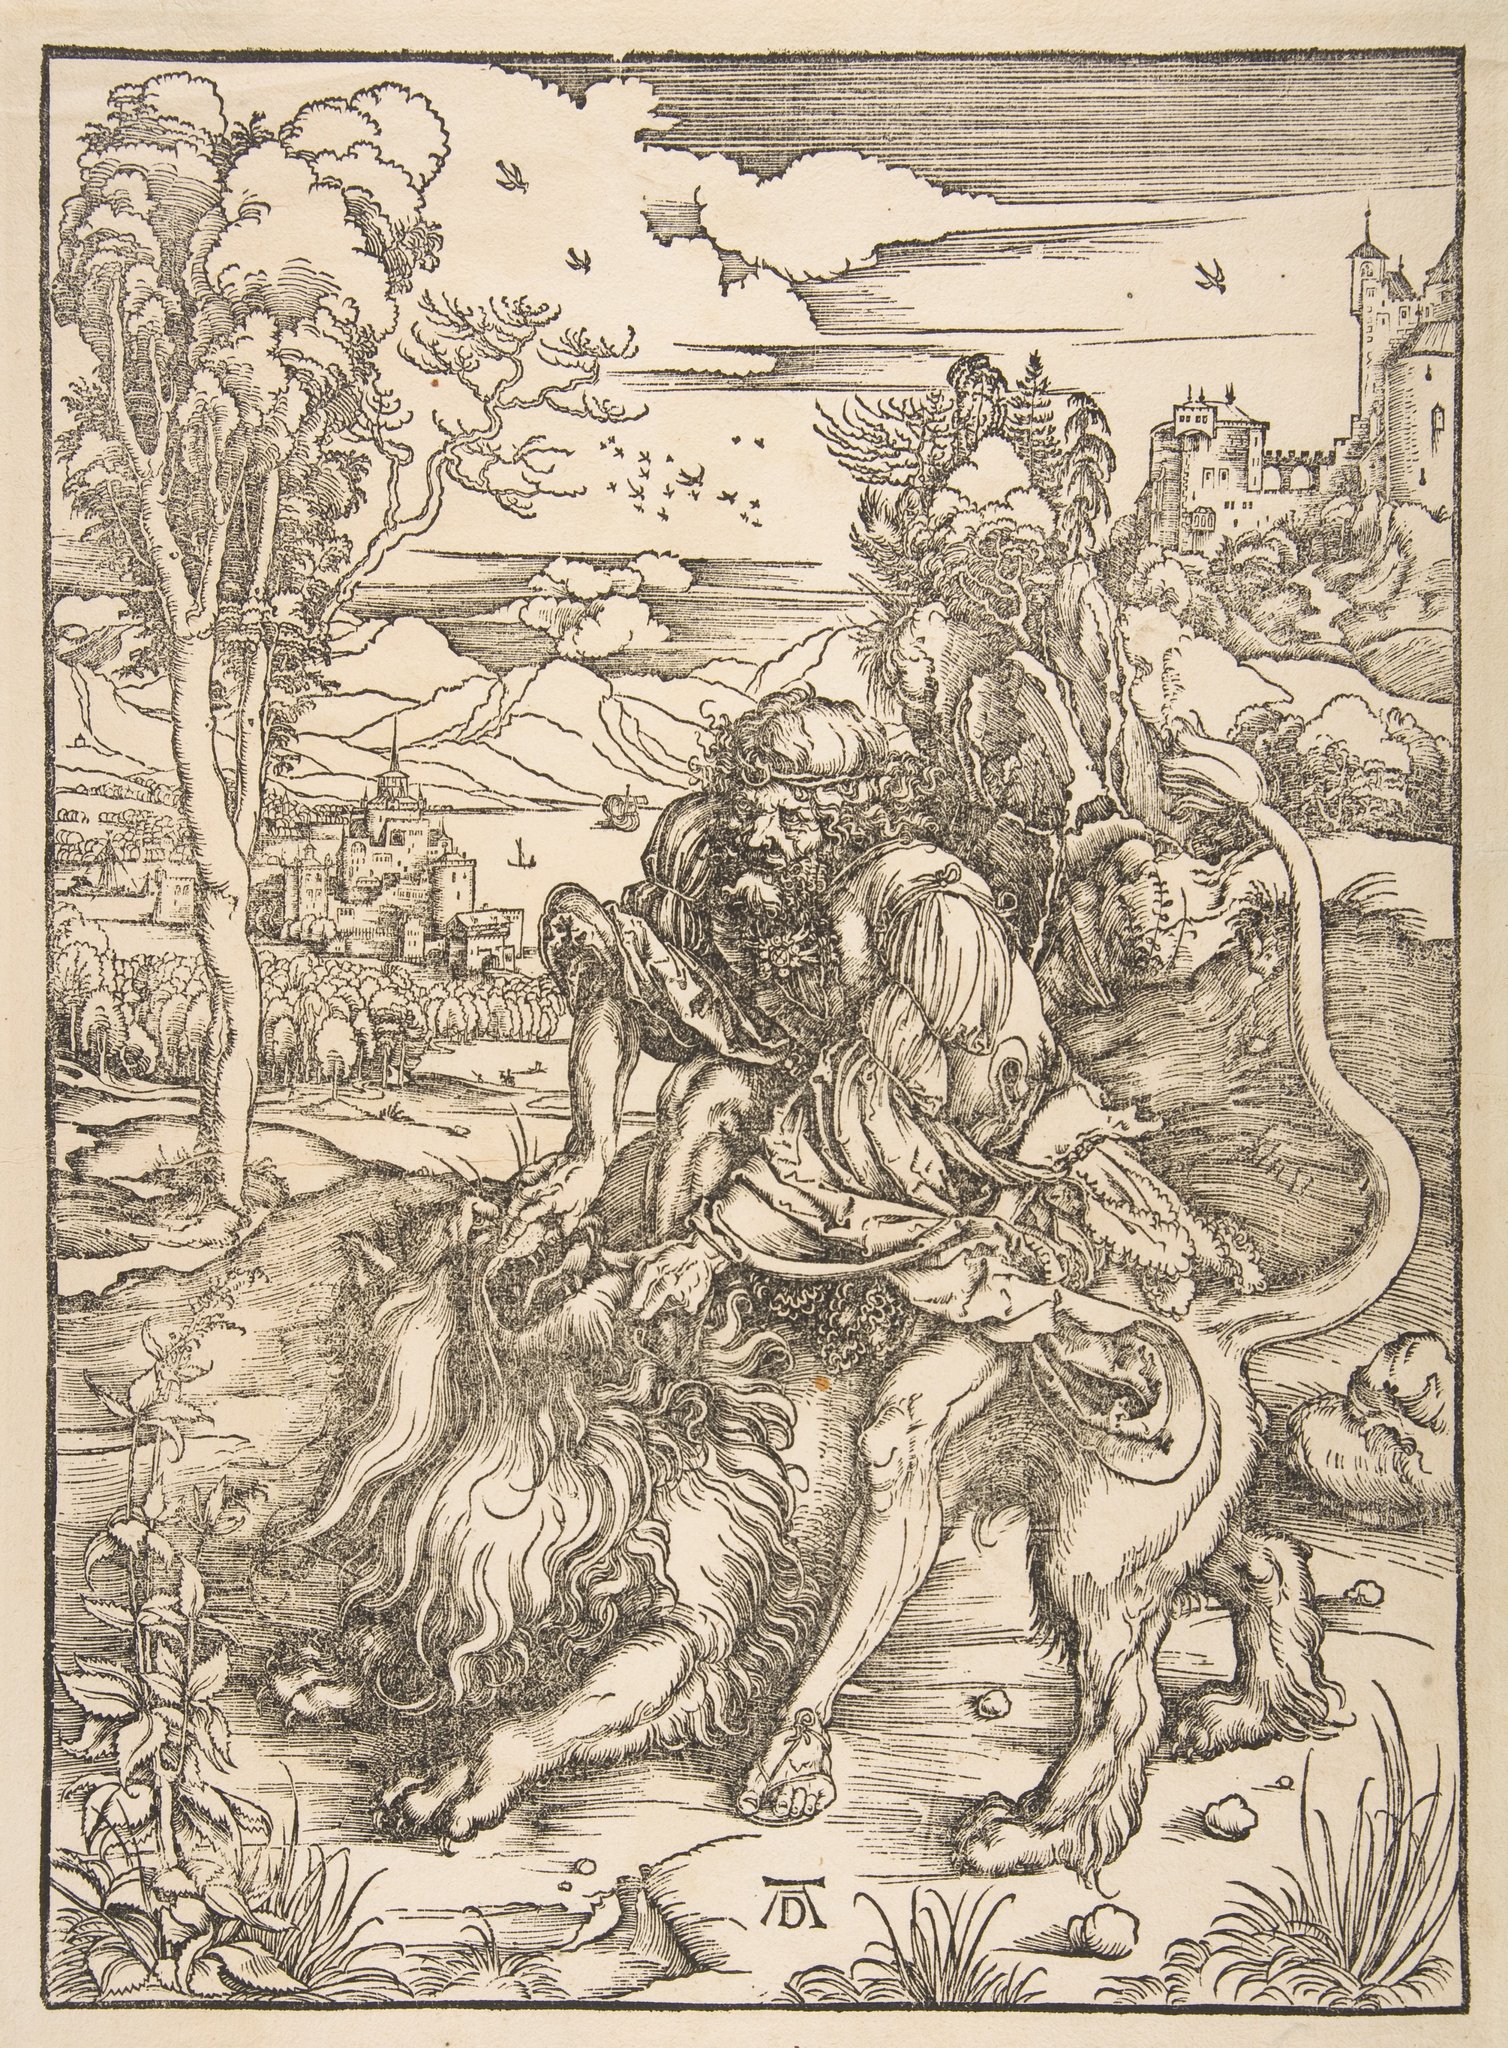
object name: print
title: Samson Rending the Lion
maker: albrecht dürer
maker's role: artist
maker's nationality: german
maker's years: 1471-1528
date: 1497-1498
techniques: woodcut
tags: lions,samson